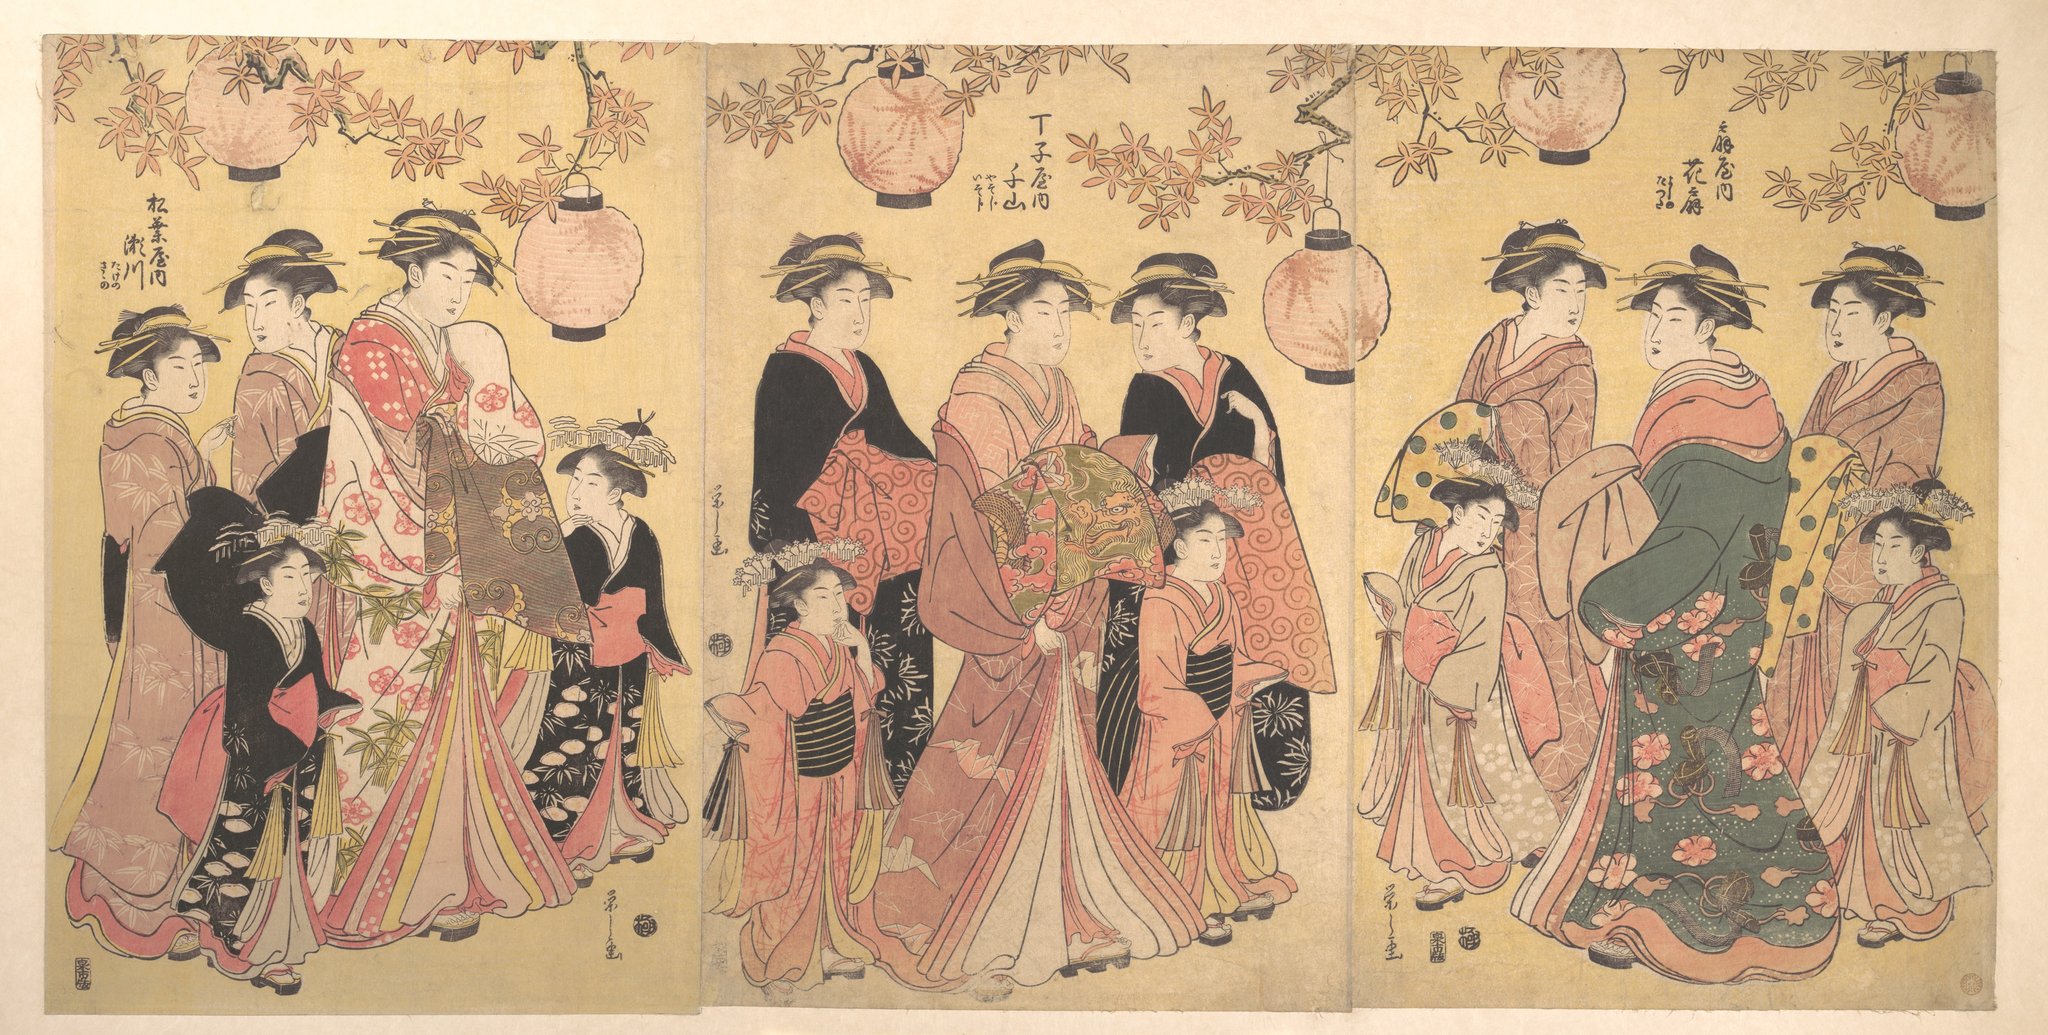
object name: print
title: The Yoshiwara Parade in Autumn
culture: japanese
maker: chōbunsai eishi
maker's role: artist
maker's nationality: japanese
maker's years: 1756-1829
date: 1793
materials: ink, paper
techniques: woodblock print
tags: girls,women